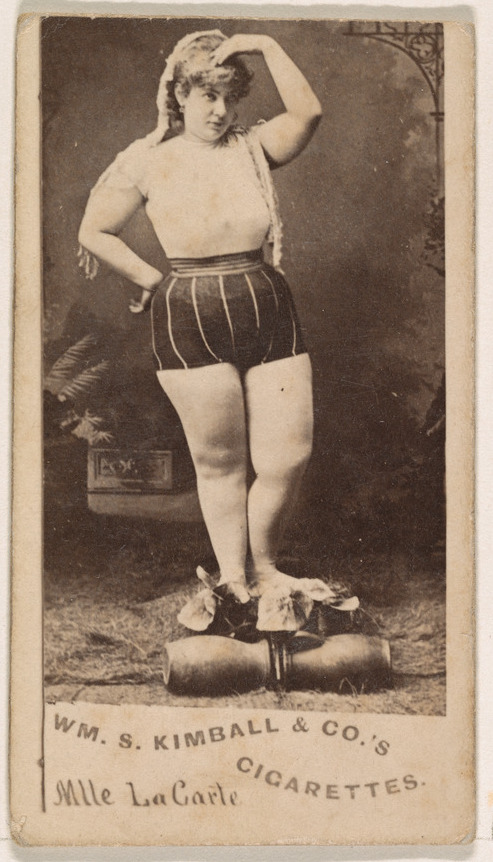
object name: photograph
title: Mlle LaCarte, from the Actresses series (N203) issued by Wm. S. Kimball & Co.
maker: william s. kimball & company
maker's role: publisher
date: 1889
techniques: color lithograph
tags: portraits,women,actresses